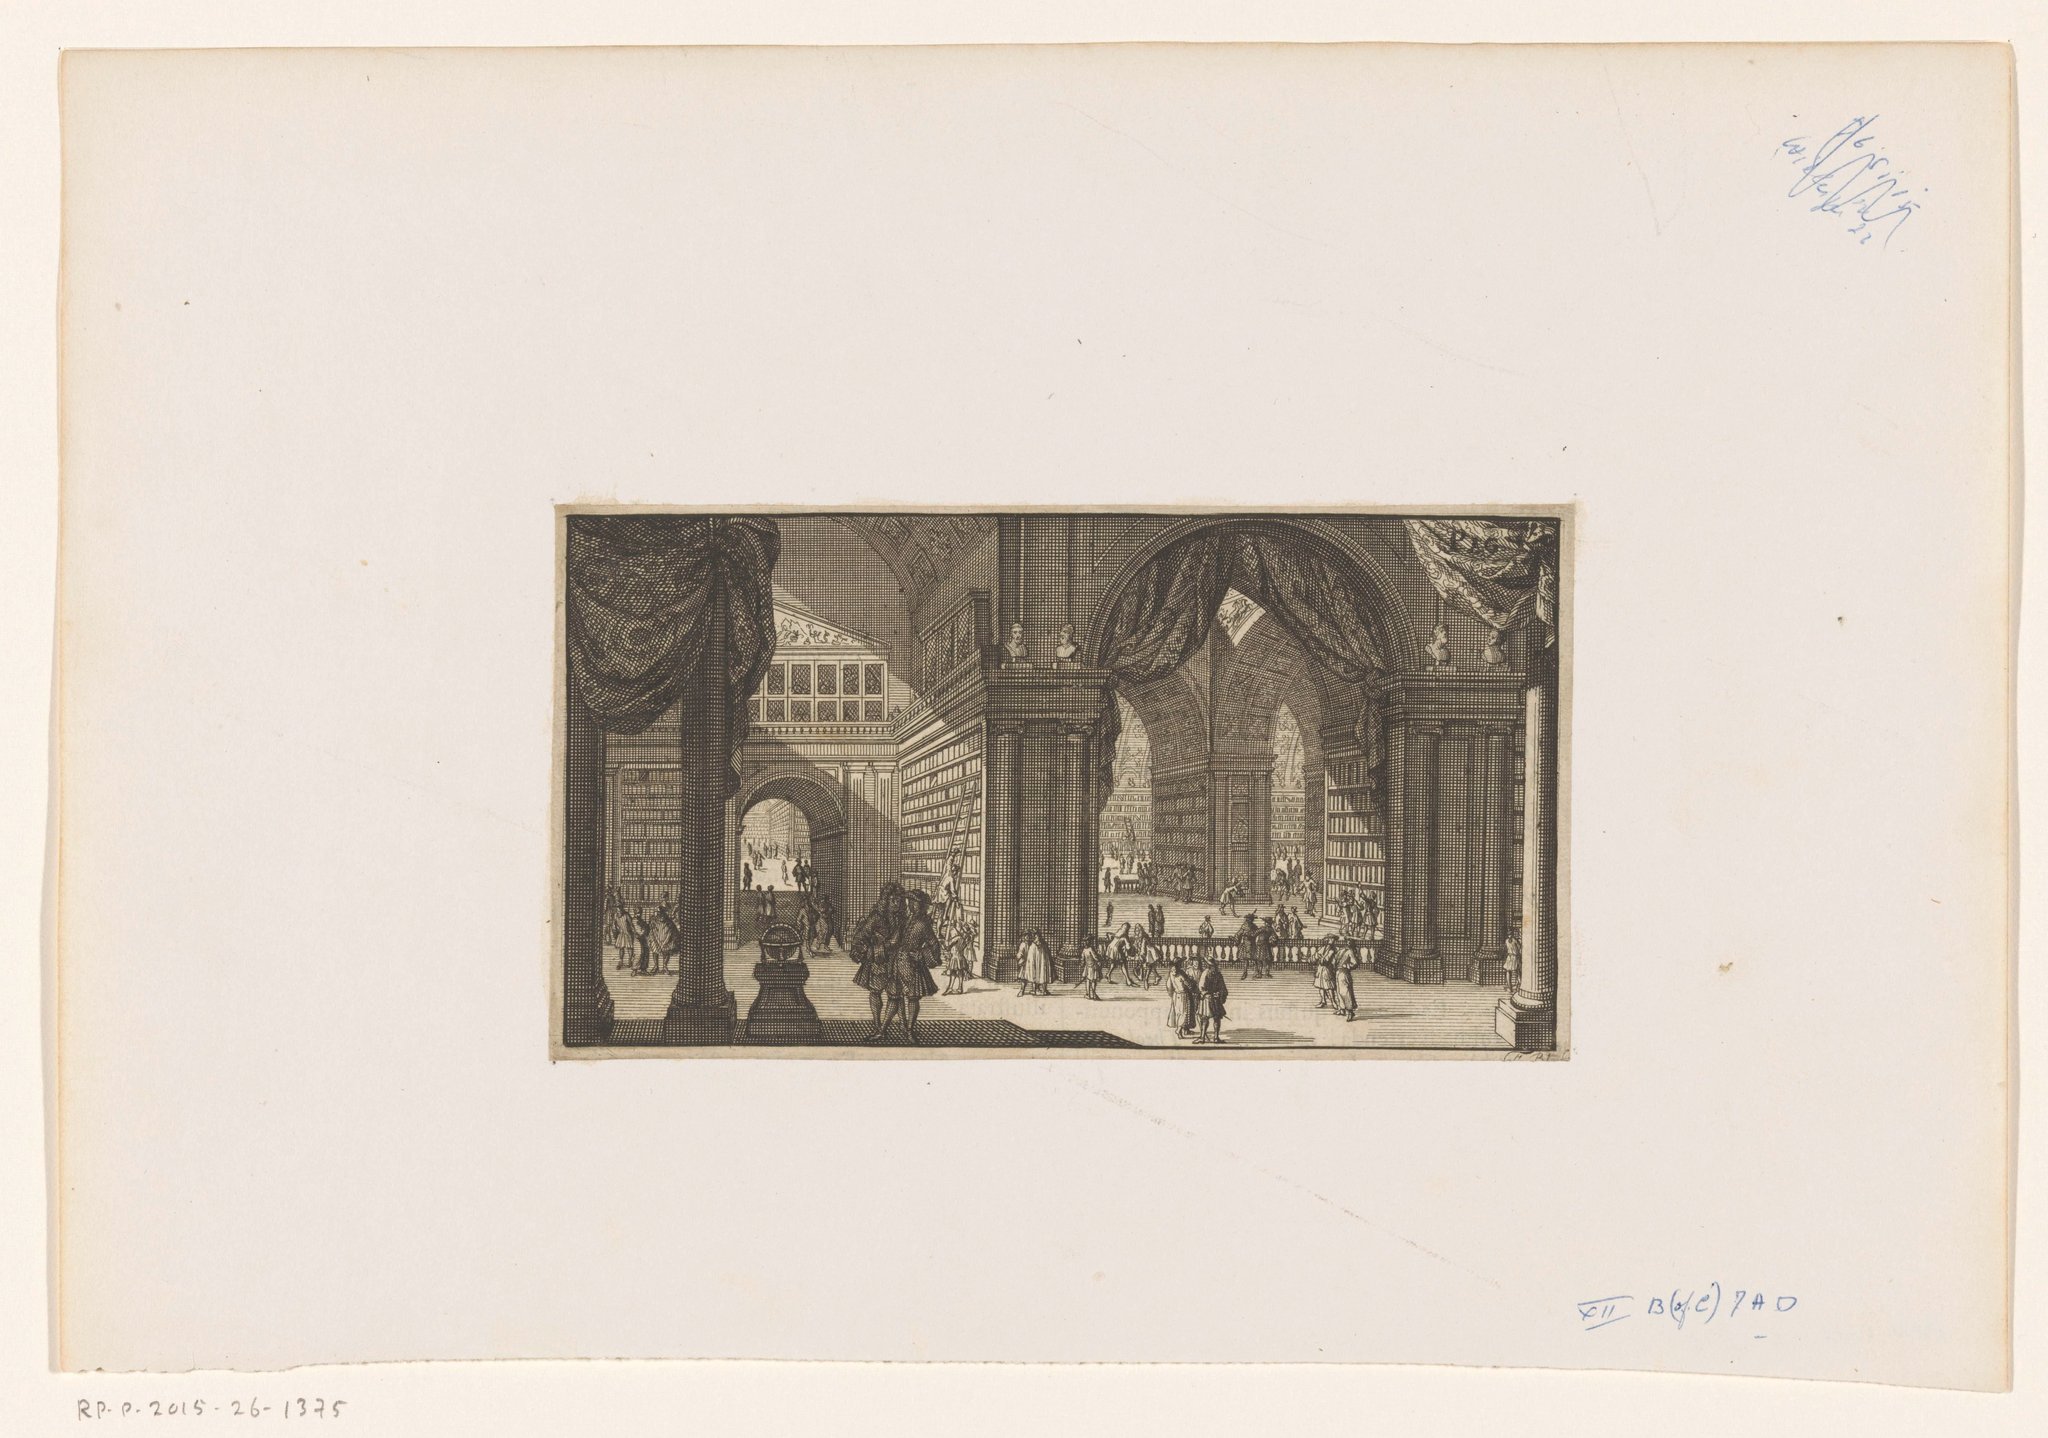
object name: book illustration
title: Bibliotheek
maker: Anonymous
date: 1700-1799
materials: paper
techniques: etching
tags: bookshelves, public library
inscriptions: collector's mark: Lugt 2228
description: Interieur van een drukbezochte bibliotheek verspreid over meerdere ruimtes, voorzien van cassetteplafonds en zuilen. Rechtsboven een onduidelijk paginanummer.